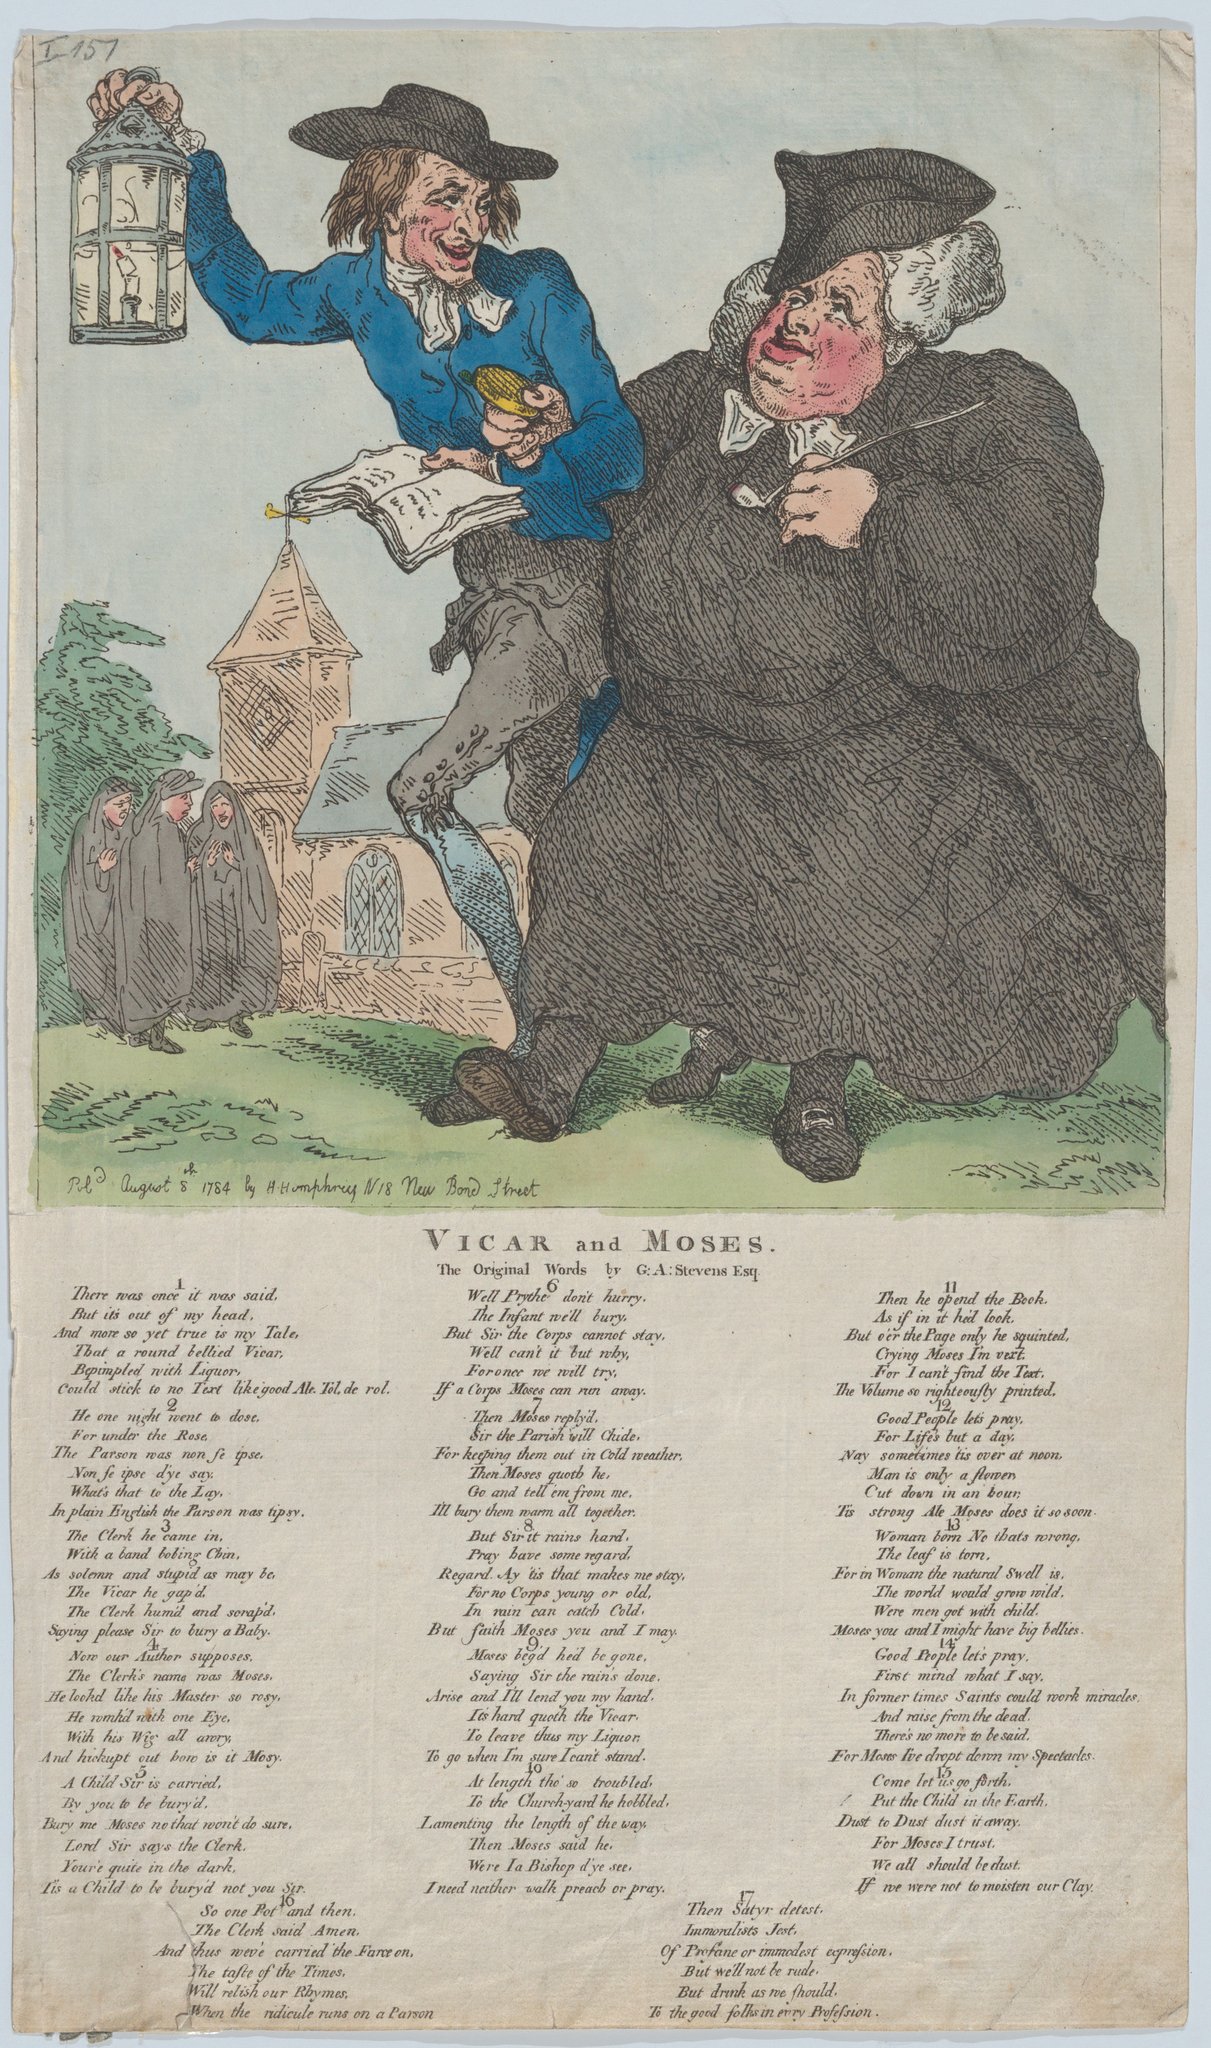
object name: print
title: Vicar & Moses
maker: thomas rowlandson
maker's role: artist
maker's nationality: british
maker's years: 1757-1827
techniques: etching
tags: satire,men